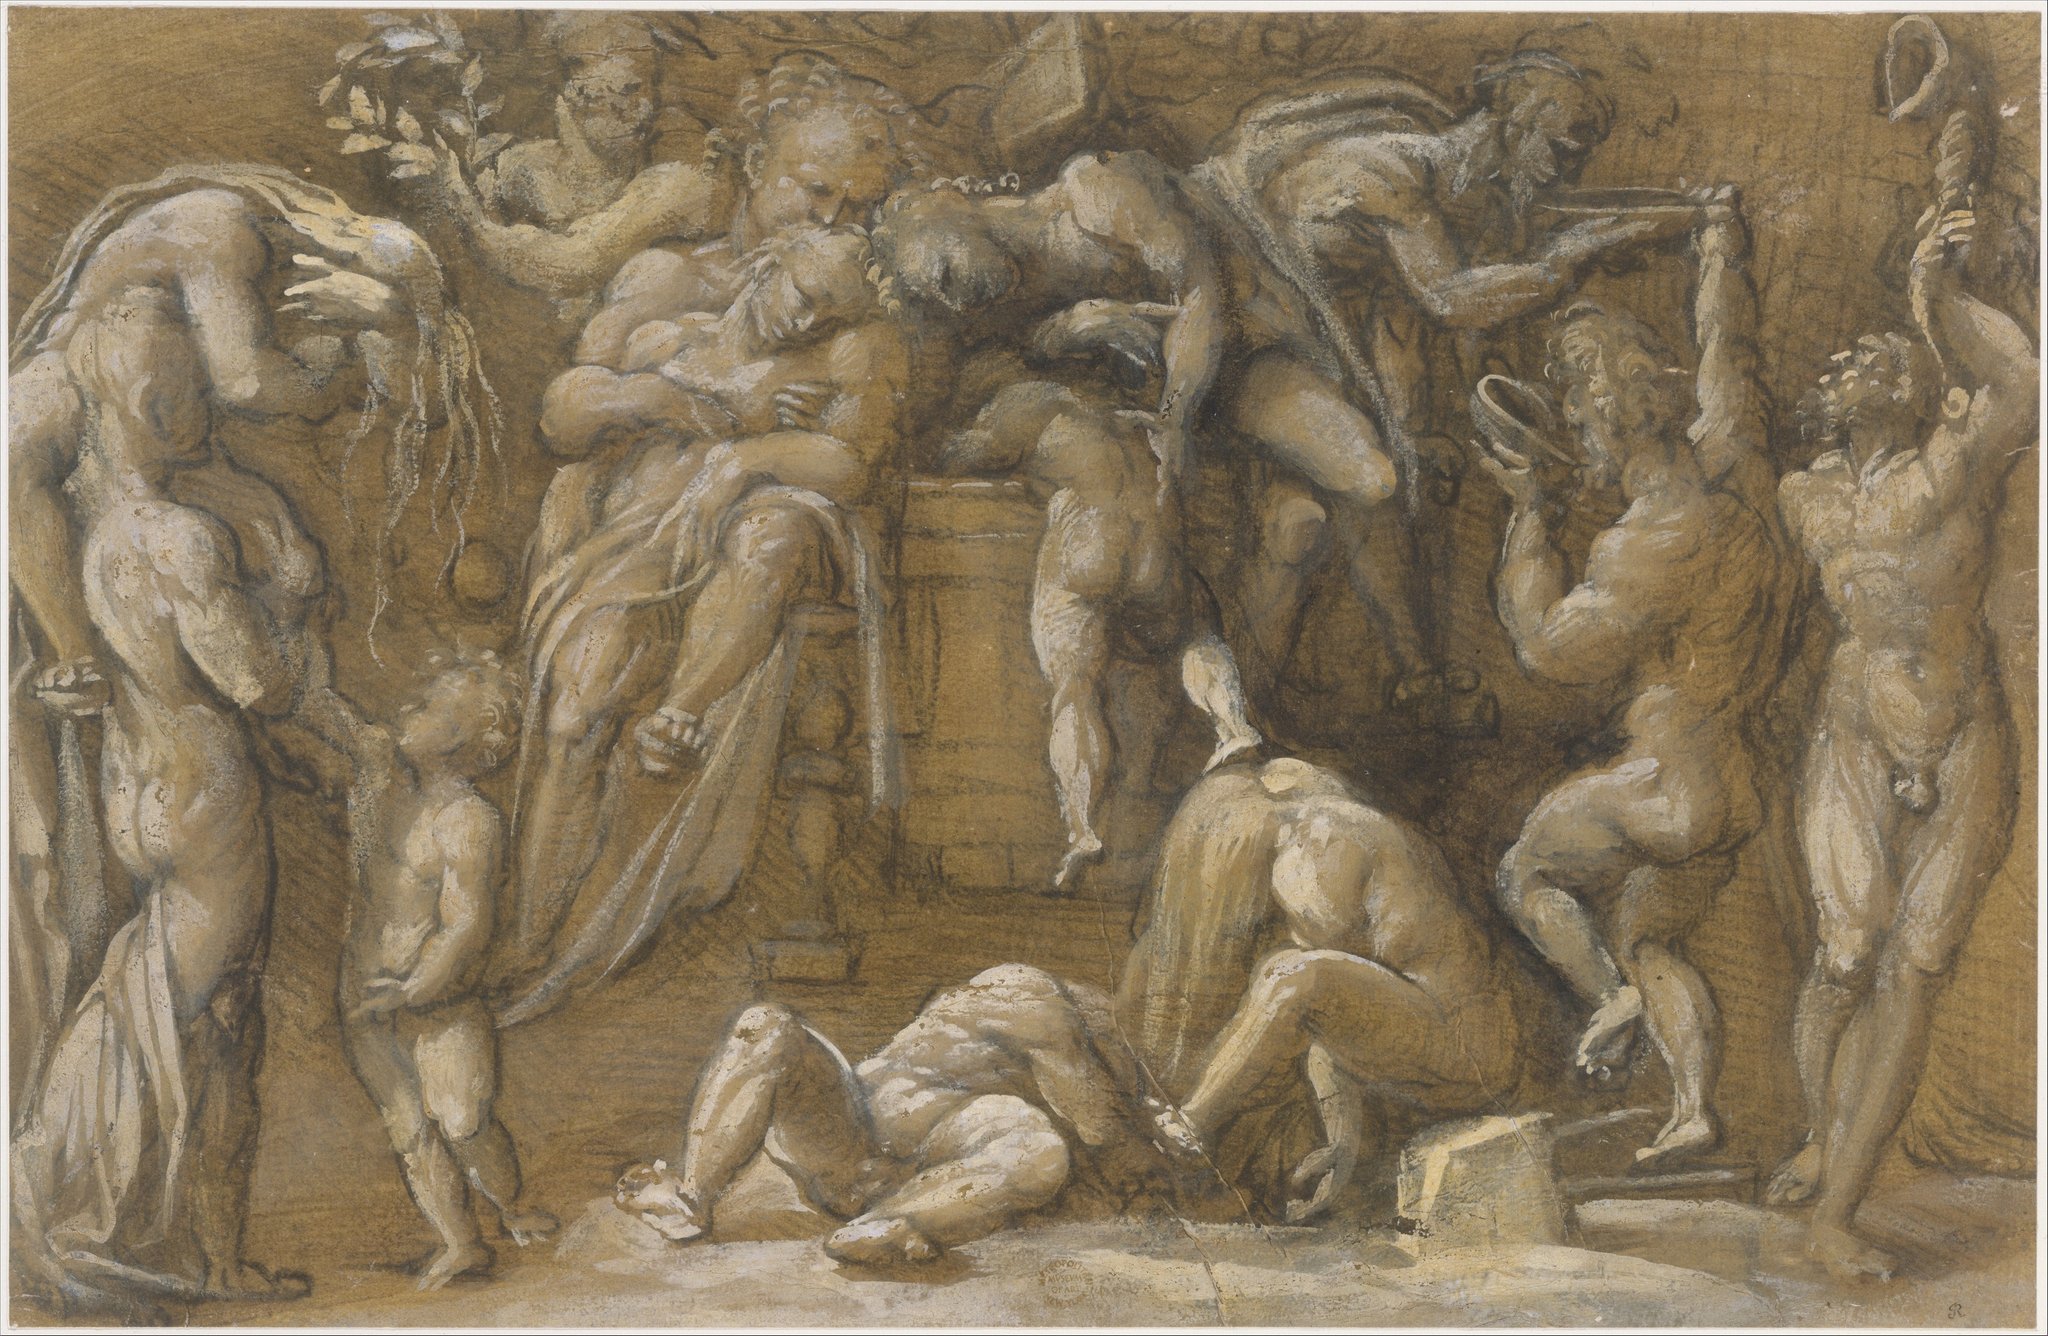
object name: drawing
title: Bacchanalian Scene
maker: amico aspertini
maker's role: artist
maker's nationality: italian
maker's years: 1474-1552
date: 1520-1535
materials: chalk, paper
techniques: highlighting, wash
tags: male nudes,drinking